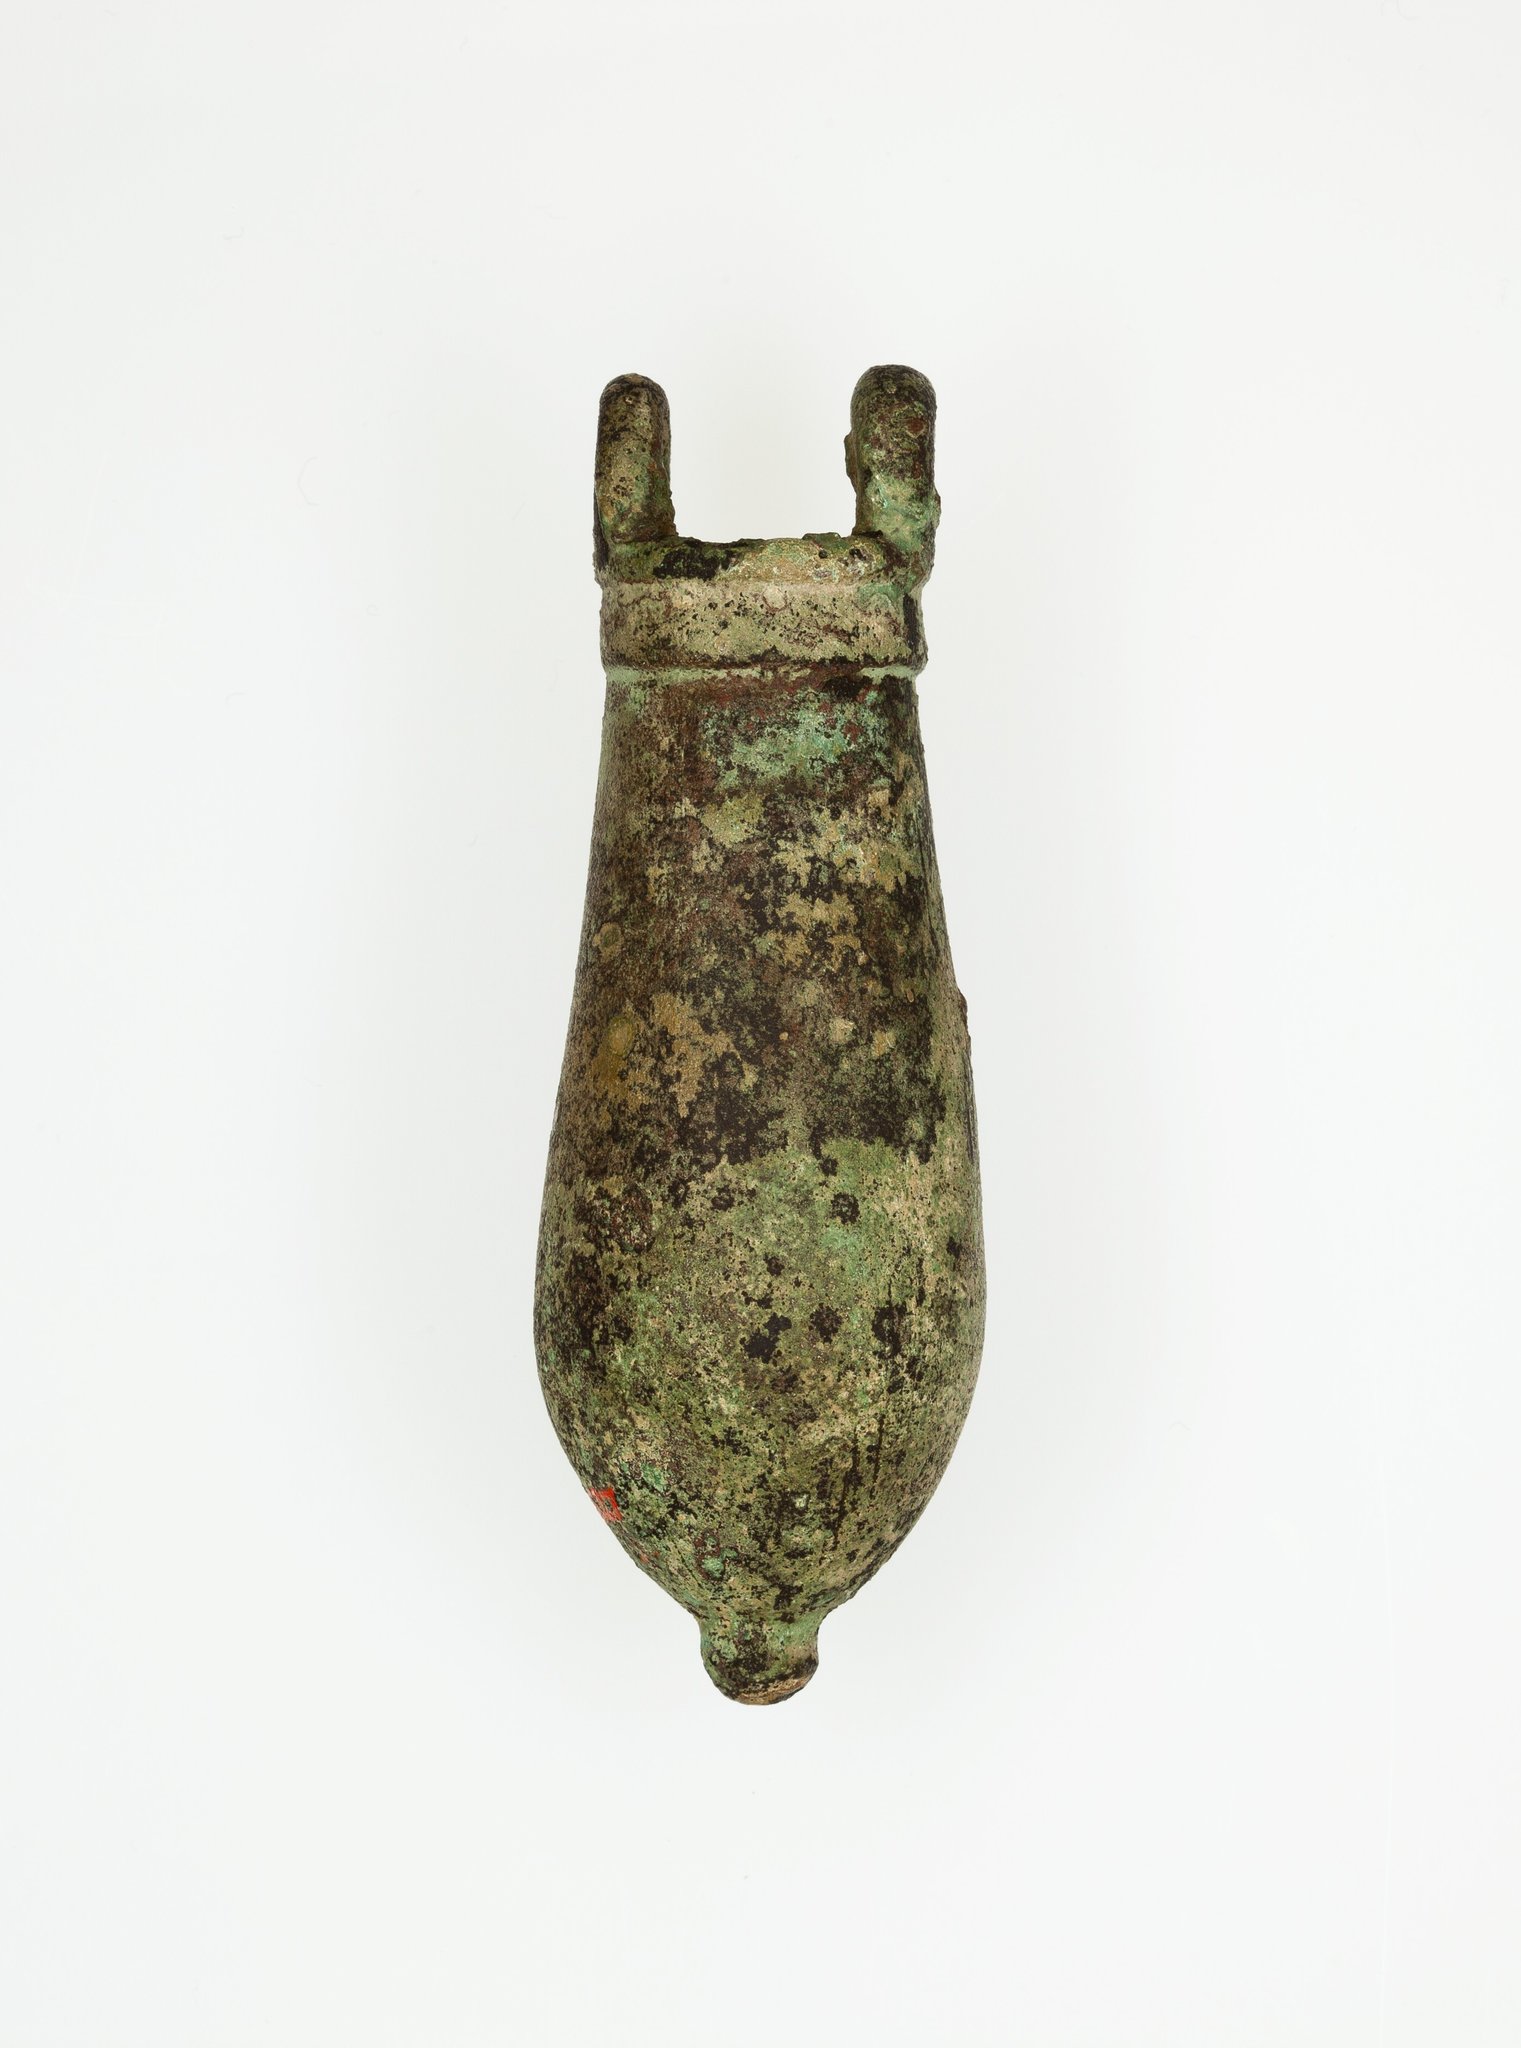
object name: situla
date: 600 BCE-100 CE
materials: copper alloy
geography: egypt